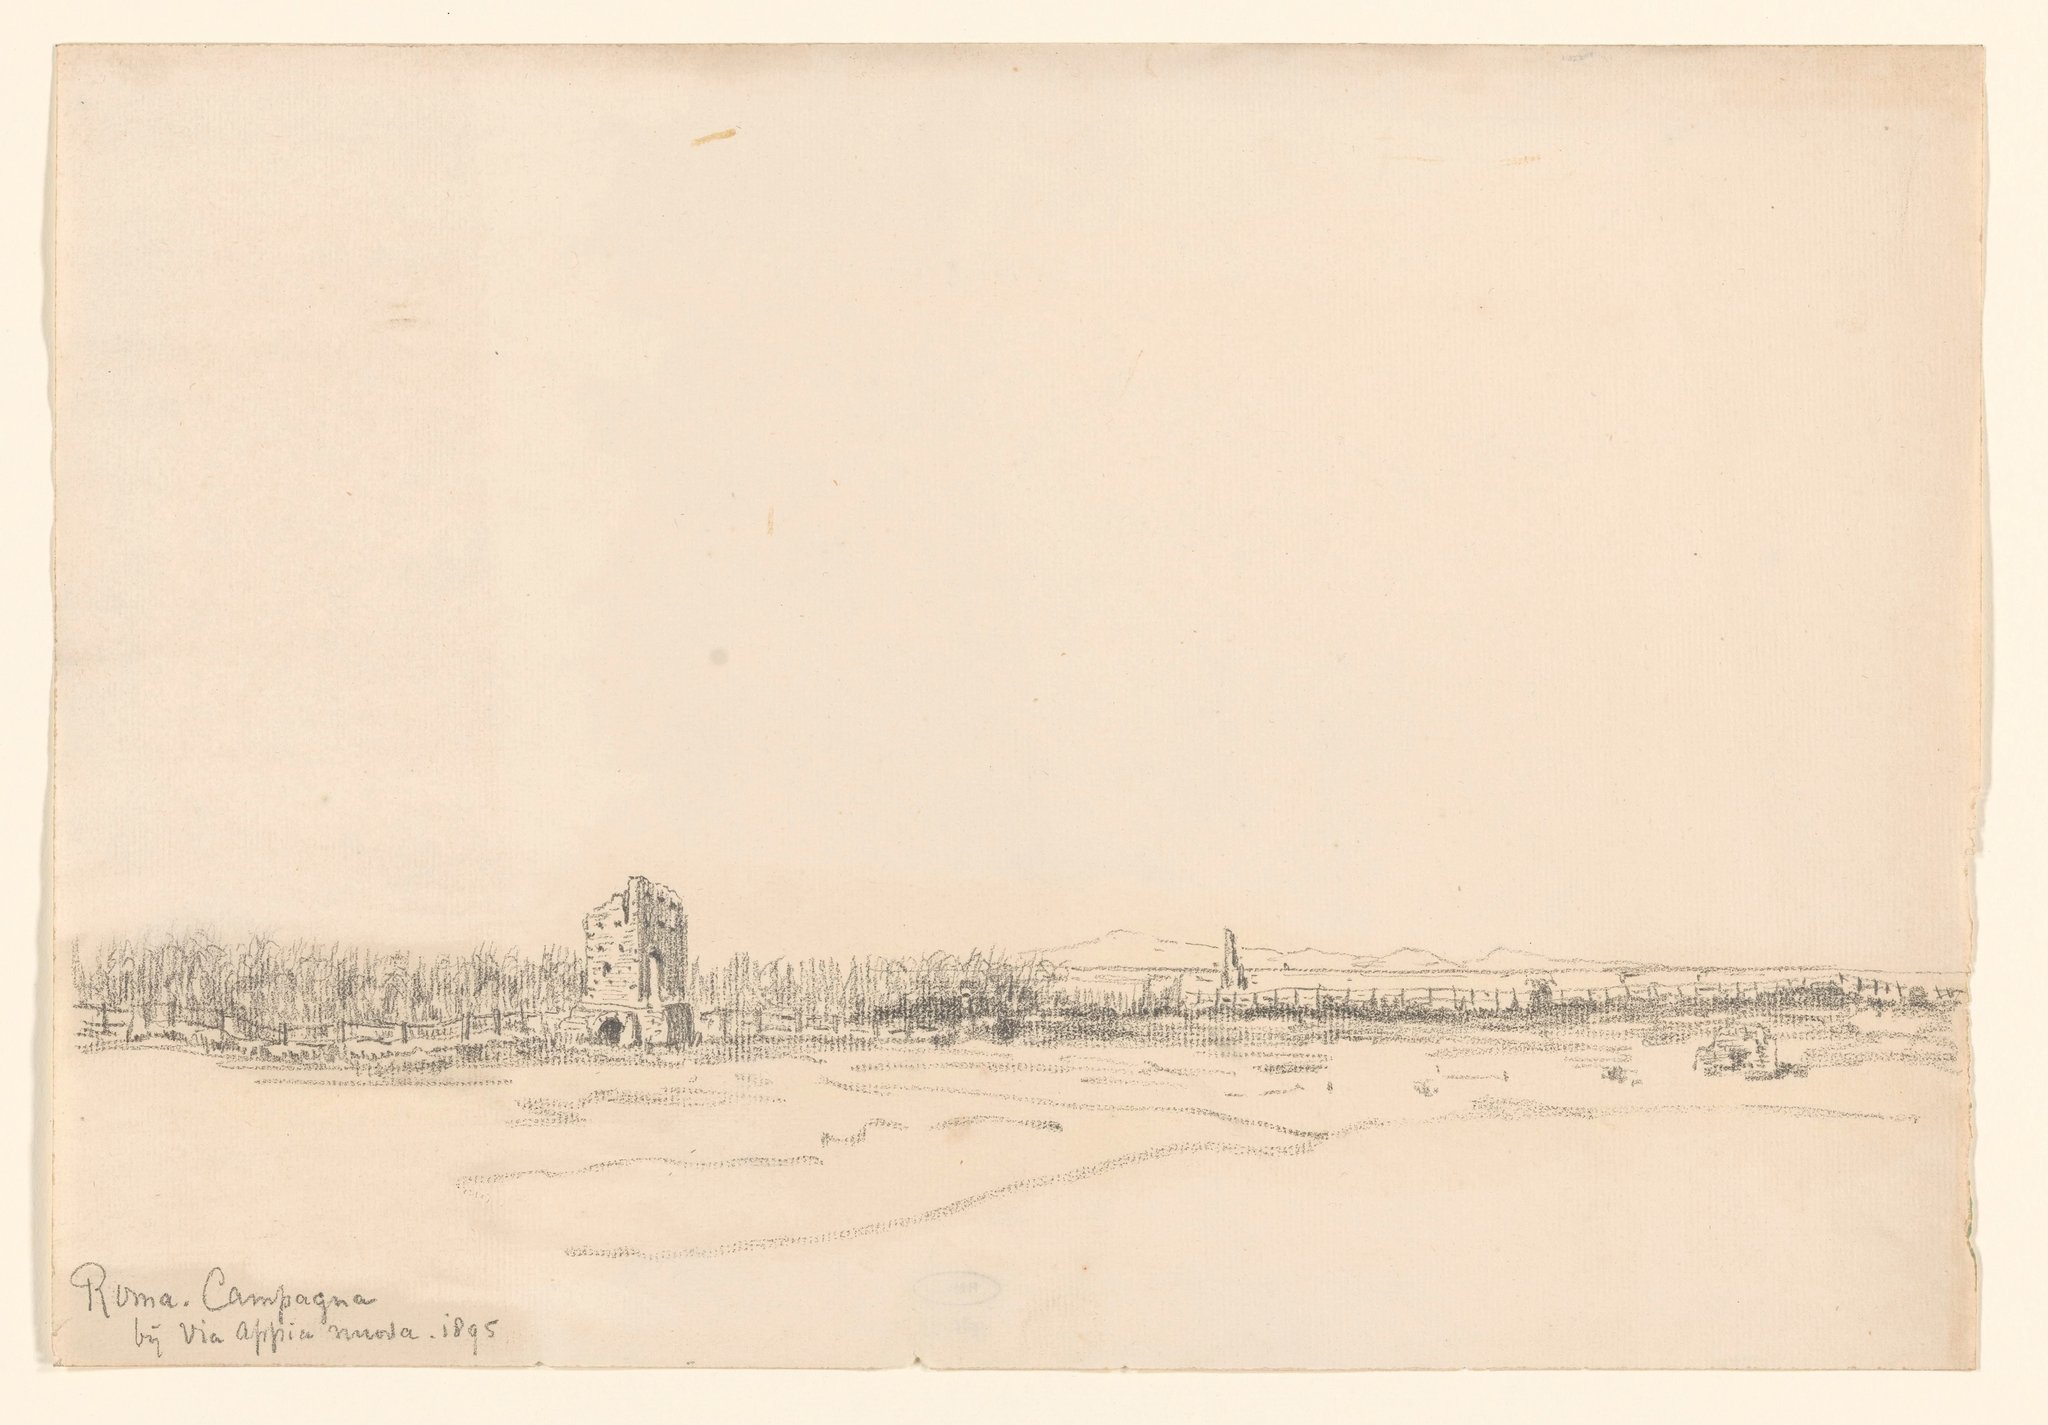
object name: drawing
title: Gezicht bij de Via Appia nuova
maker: carel vosmaer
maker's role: draughtsman, print maker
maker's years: 1826-1888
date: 1895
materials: paper, pencil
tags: city-view, and landscape with man-made constructions, italy